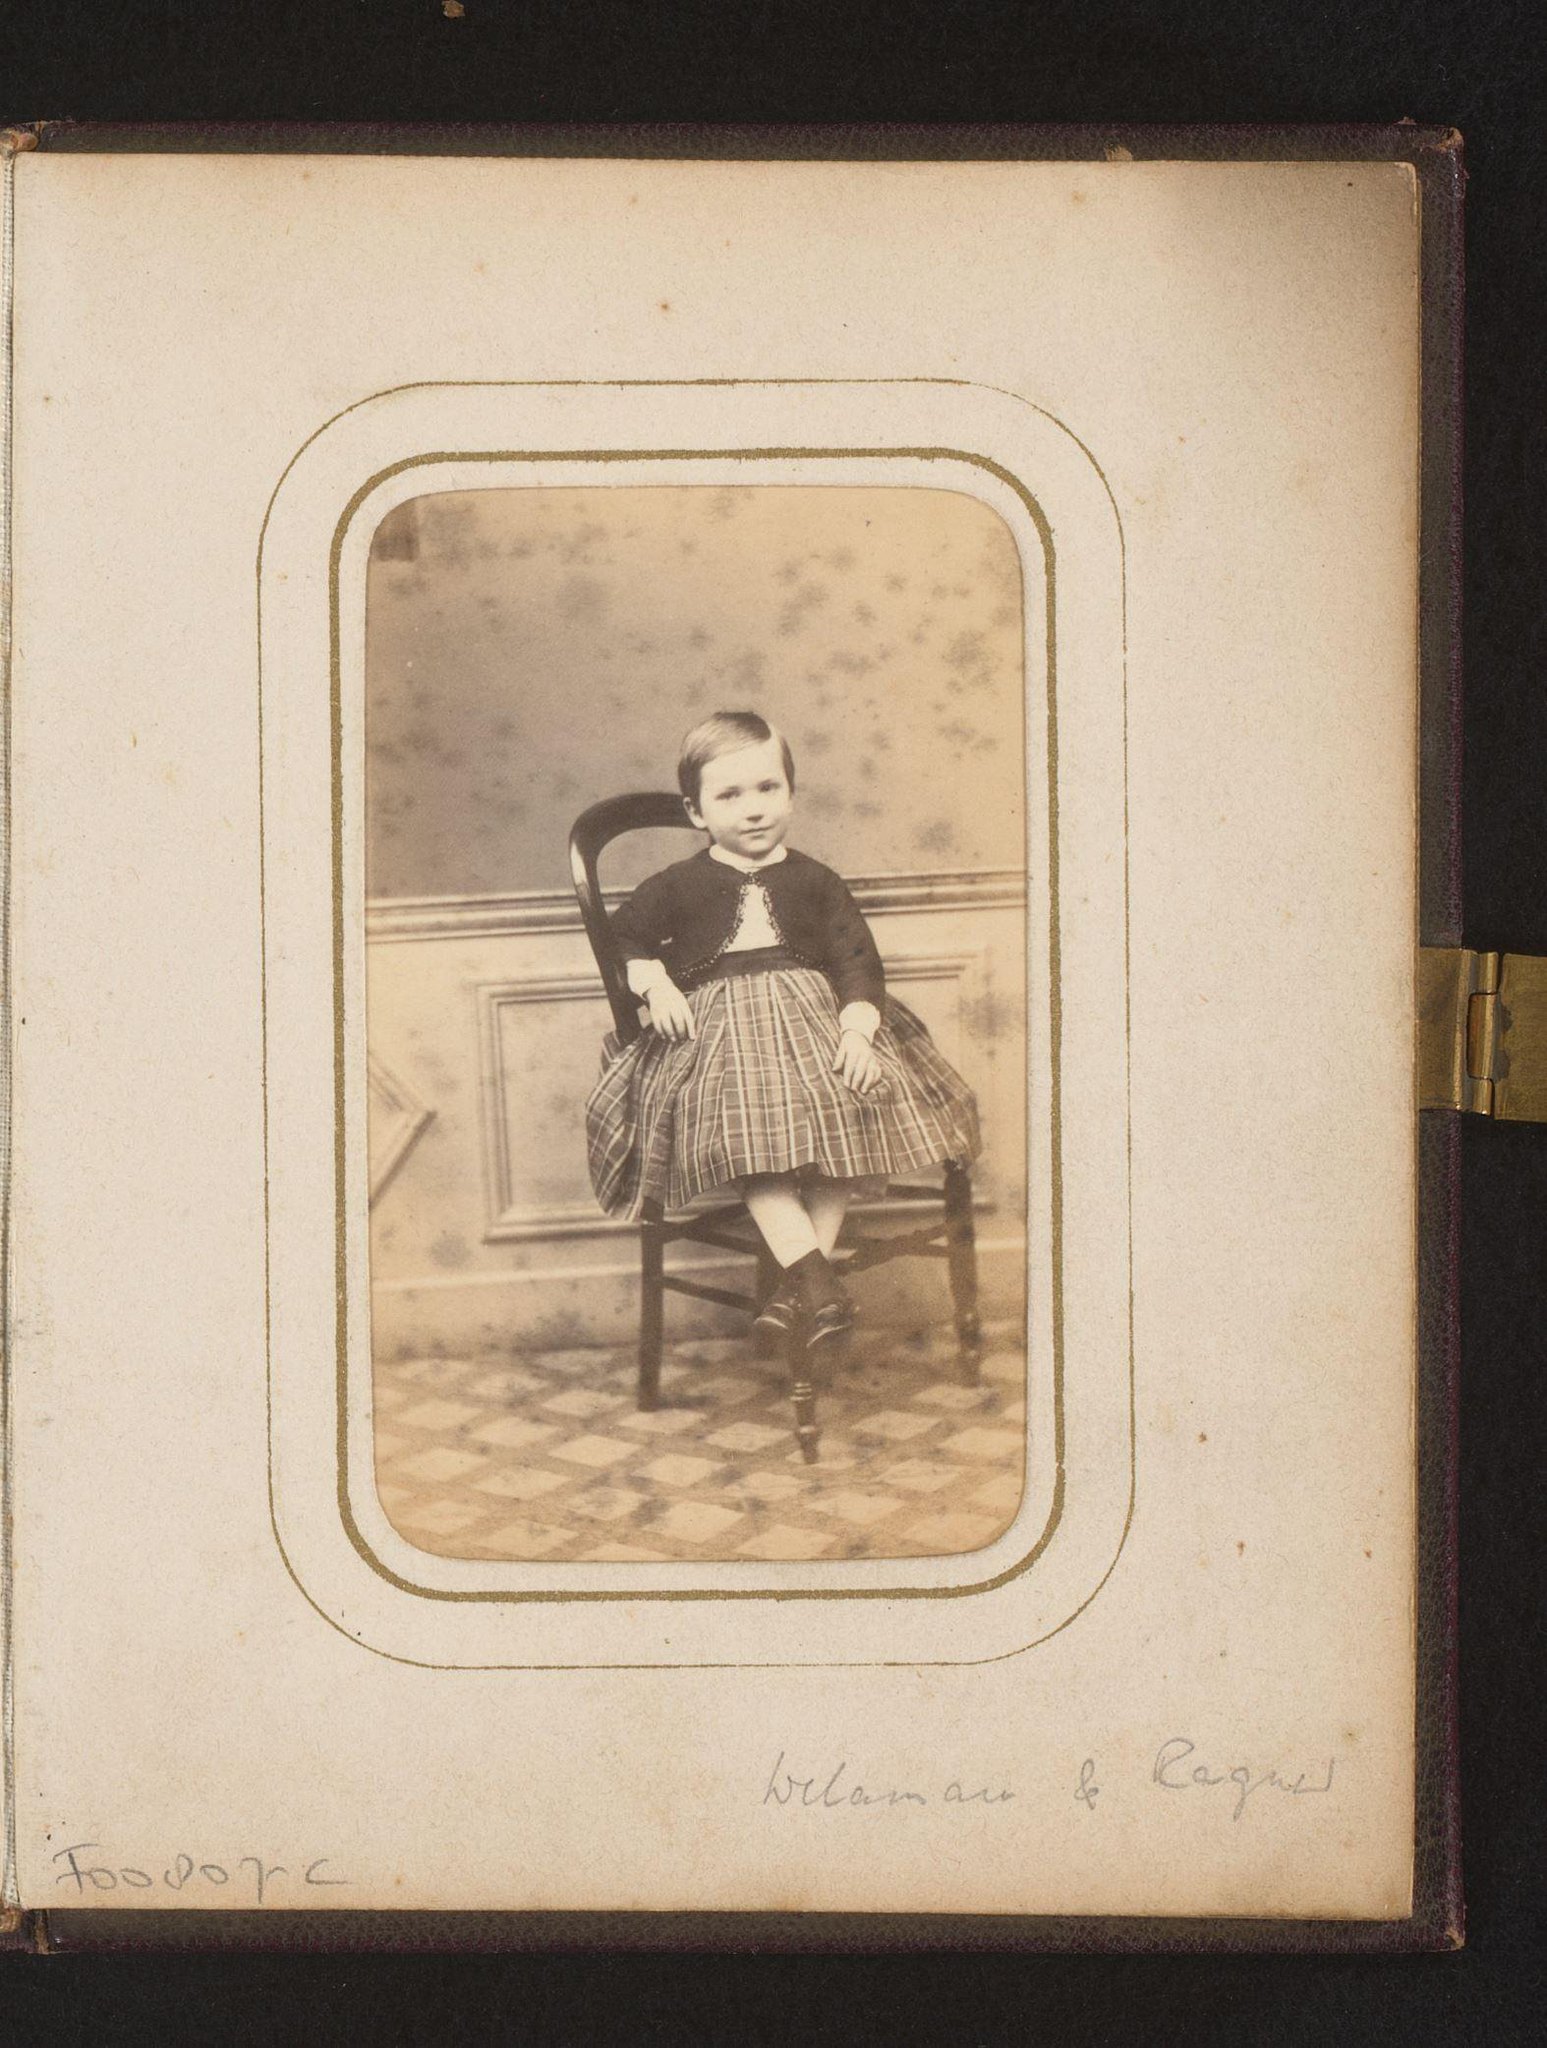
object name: album leaf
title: Portret van een meisje, zittend op een stoel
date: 1860-1900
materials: cardboard, photographic support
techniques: albumen print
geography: elbeuf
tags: historical persons - bb - woman, girl (child between toddler and youth), chair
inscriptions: inscription: ‘A. DELAMARE & A. RAGUET/ PHOTOGRAPHES/ Succrs de Mr ROUGEOT de BRIEL/ Rue de Paris, 7, Elbeuf.’, annotation: ‘Delamar & Raguet’